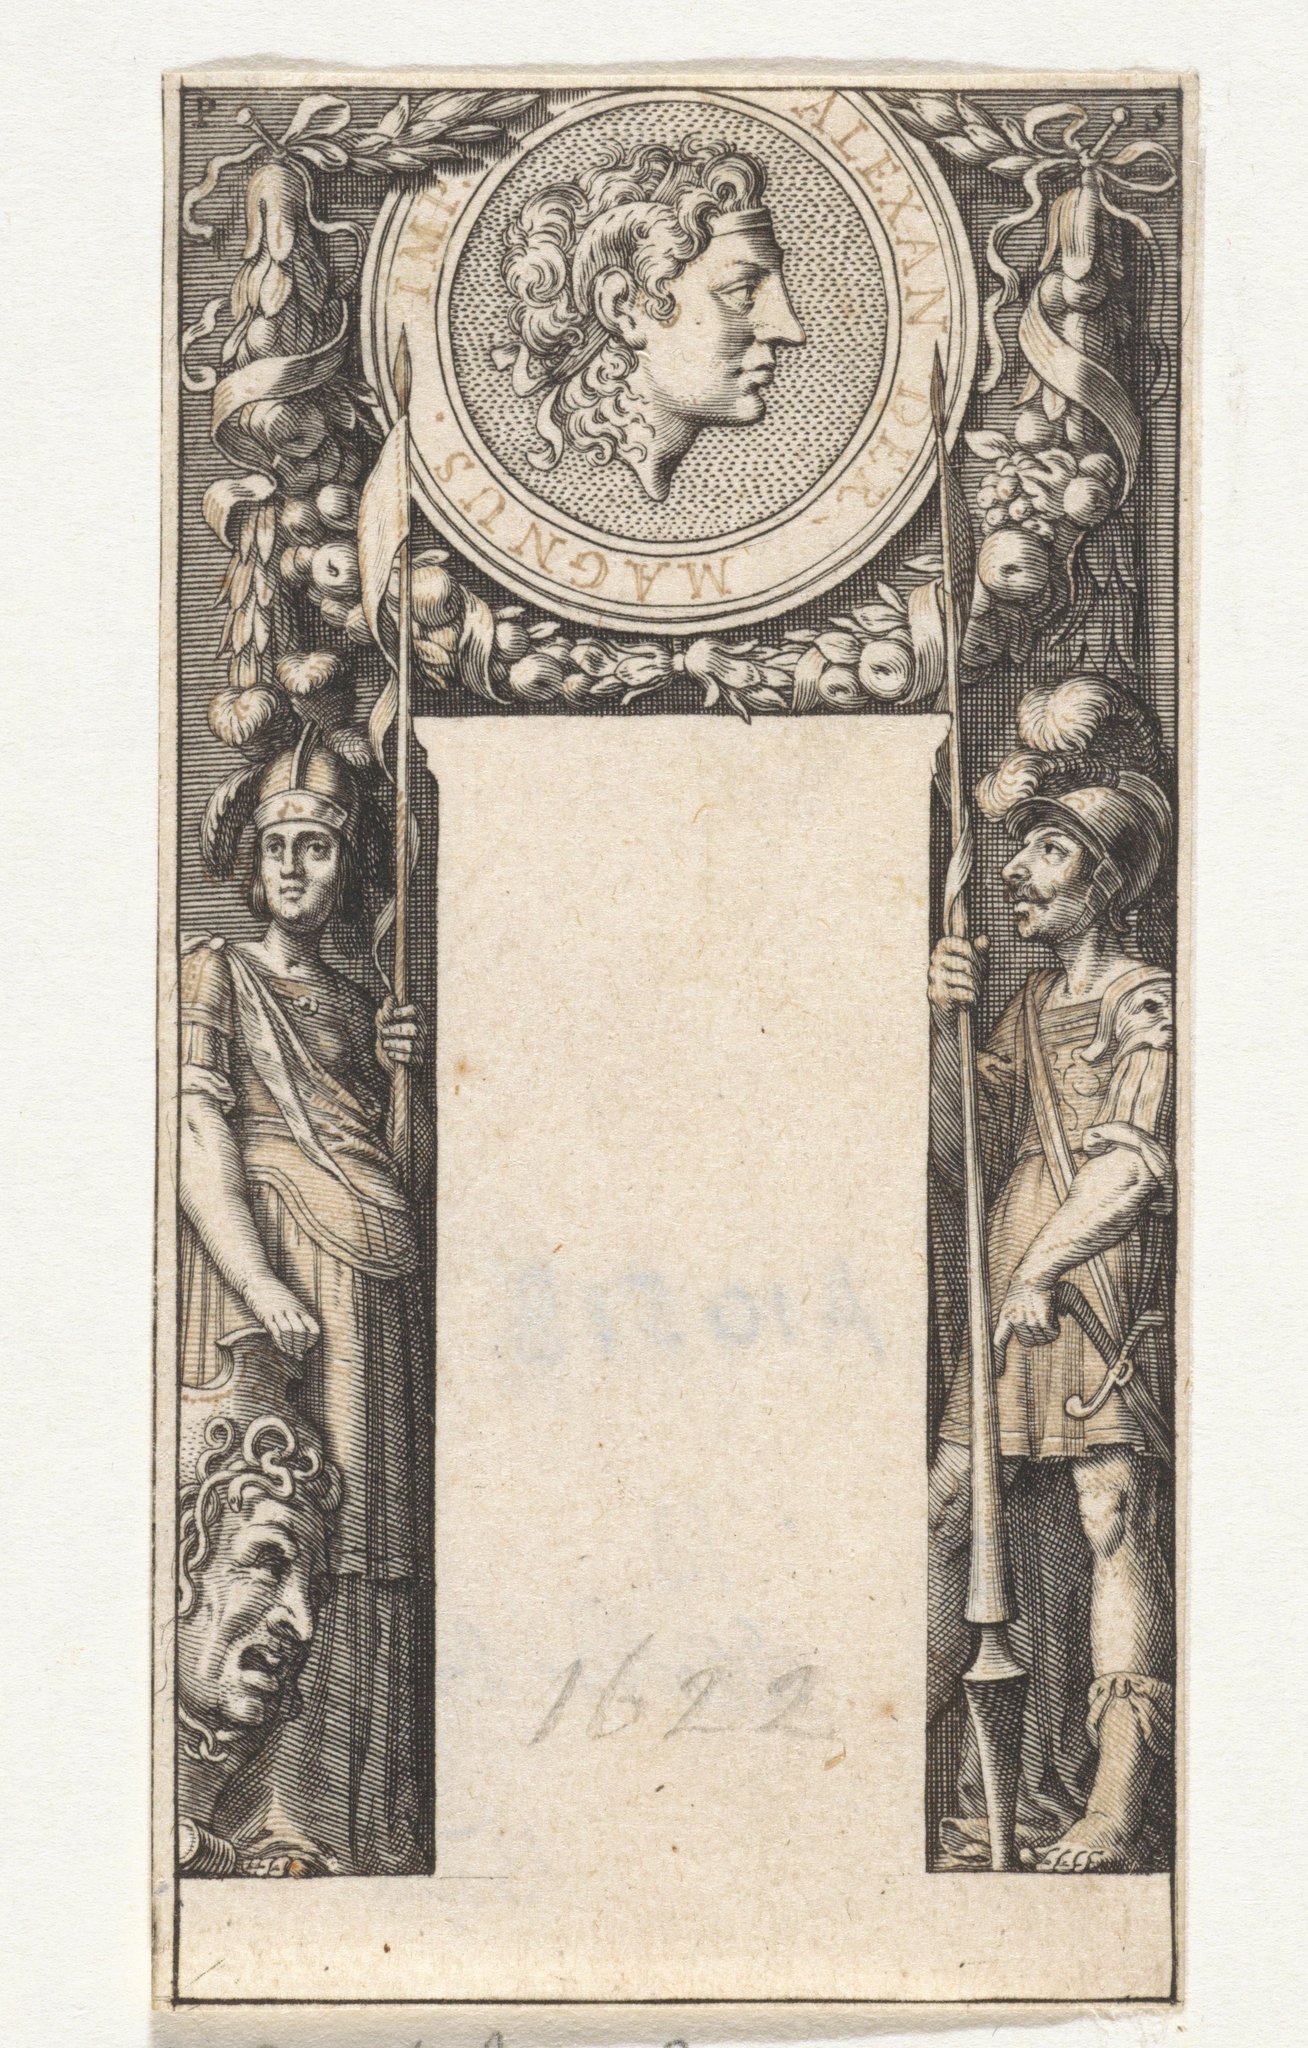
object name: titelblad, titelpagina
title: Ontwerp voor een titelpagina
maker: pieter serwouters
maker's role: draughtsman, print maker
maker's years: 1586-1657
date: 1601-1657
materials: ink, paper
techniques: engraving, etching, pen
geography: amsterdam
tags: specific aspects, allegorical aspects of minerva; minerva as patroness, specific aspects, allegorical aspects of mars; mars as patron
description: Ontwerp voor een titelpagina. Bovenaan een medaillion met de kop van Alexander de Grote, versierd met een guirlande van bladeren en vruchten. In pren is zijn naam ingevuld. Daaronder is een vlak open gelaten voor de titel van het boek. Links daarvan staat Minerva, rechts Mars.